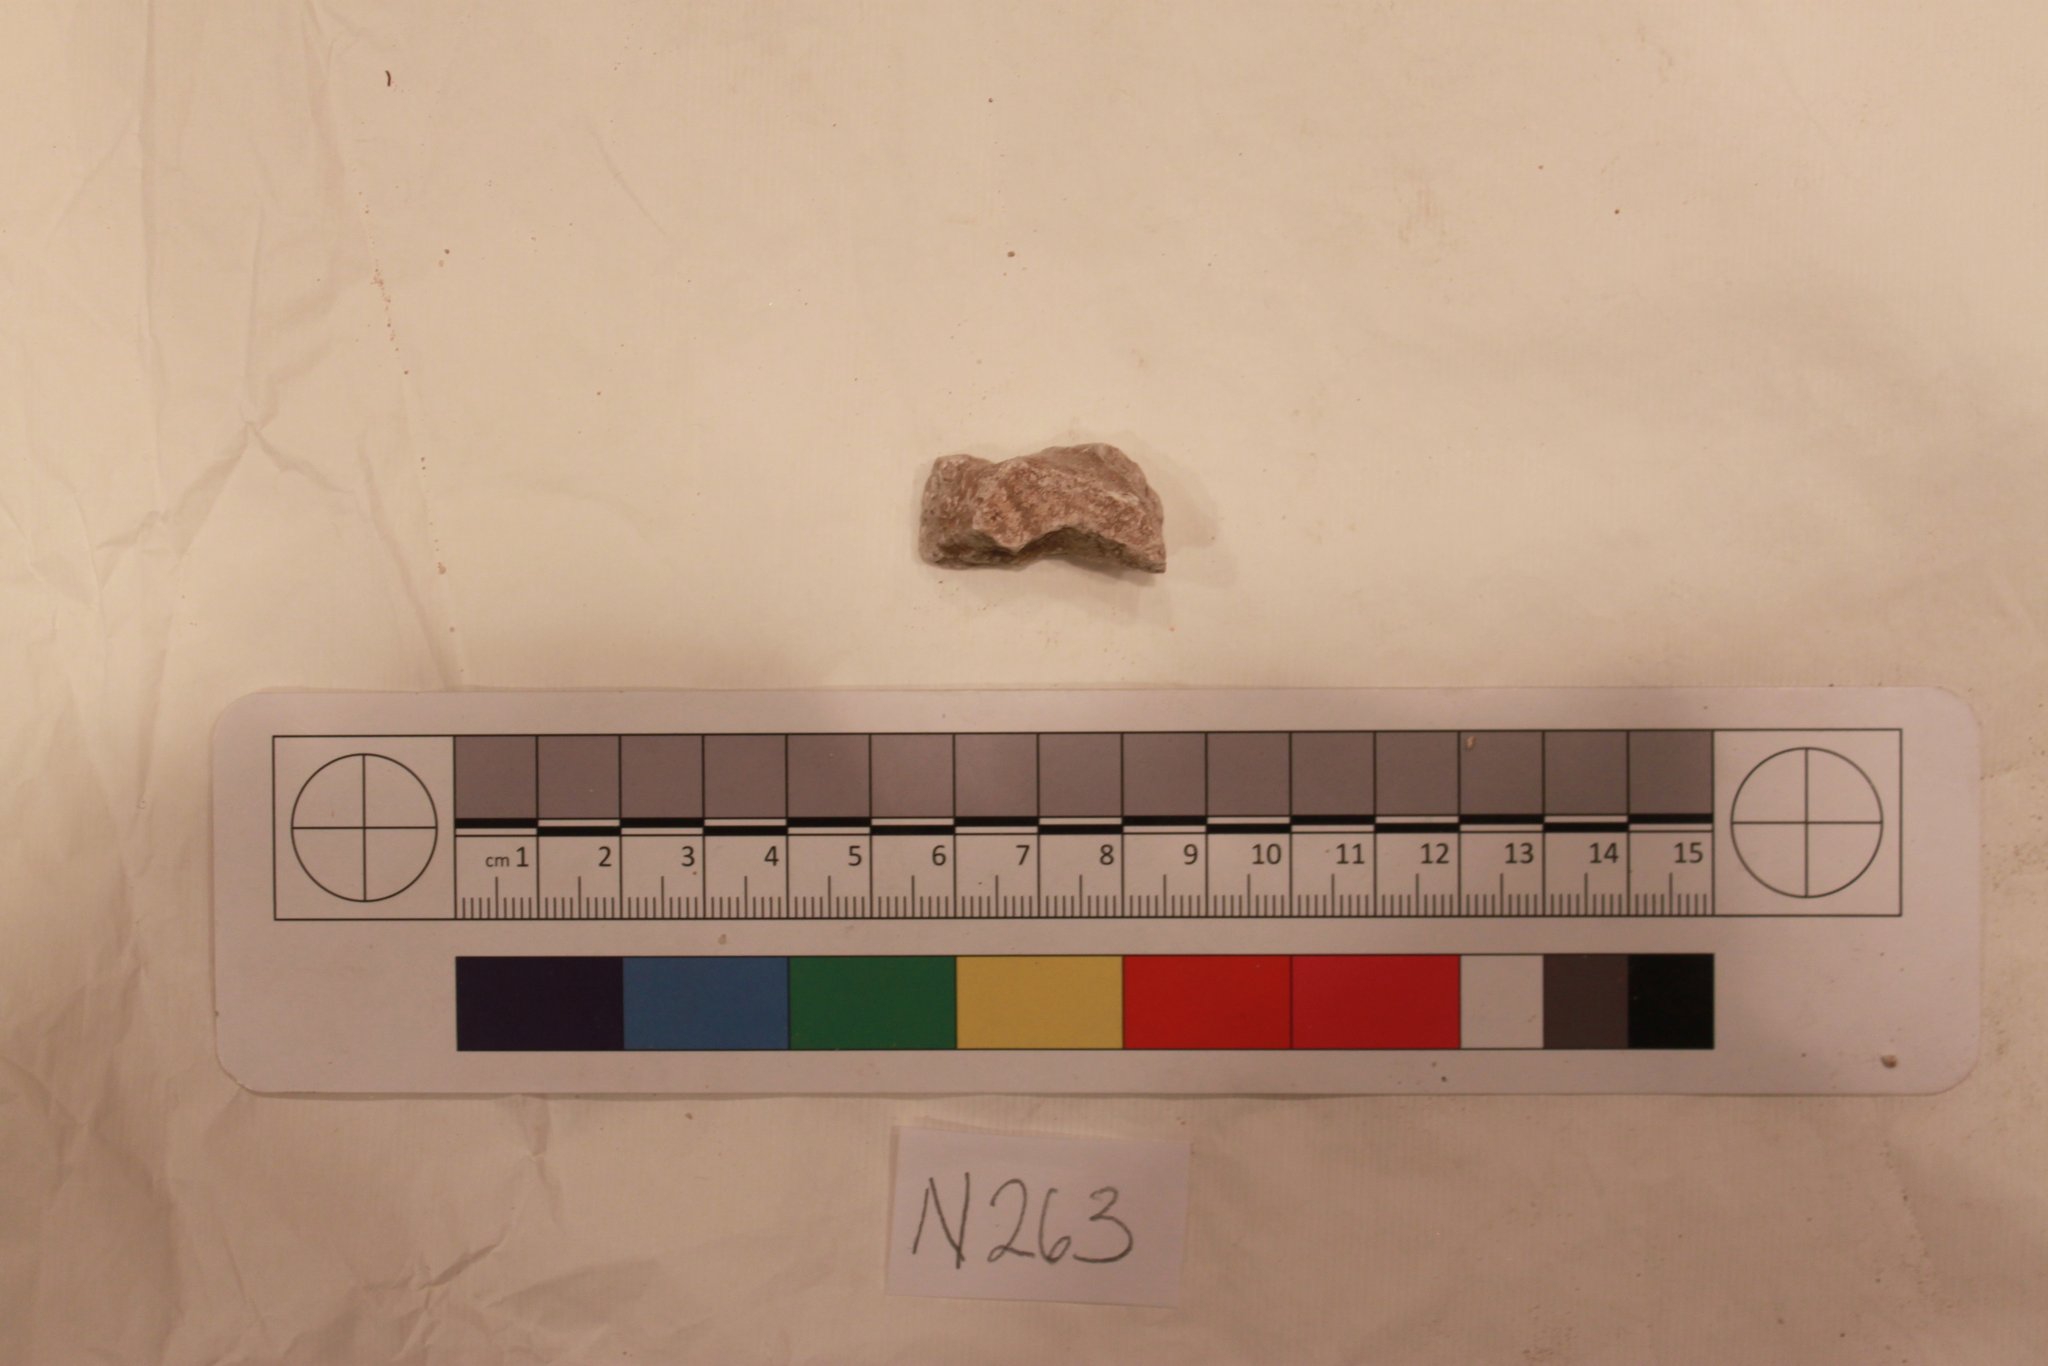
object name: fragment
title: Stucco Fragment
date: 701-1200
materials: plaster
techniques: carving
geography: iran